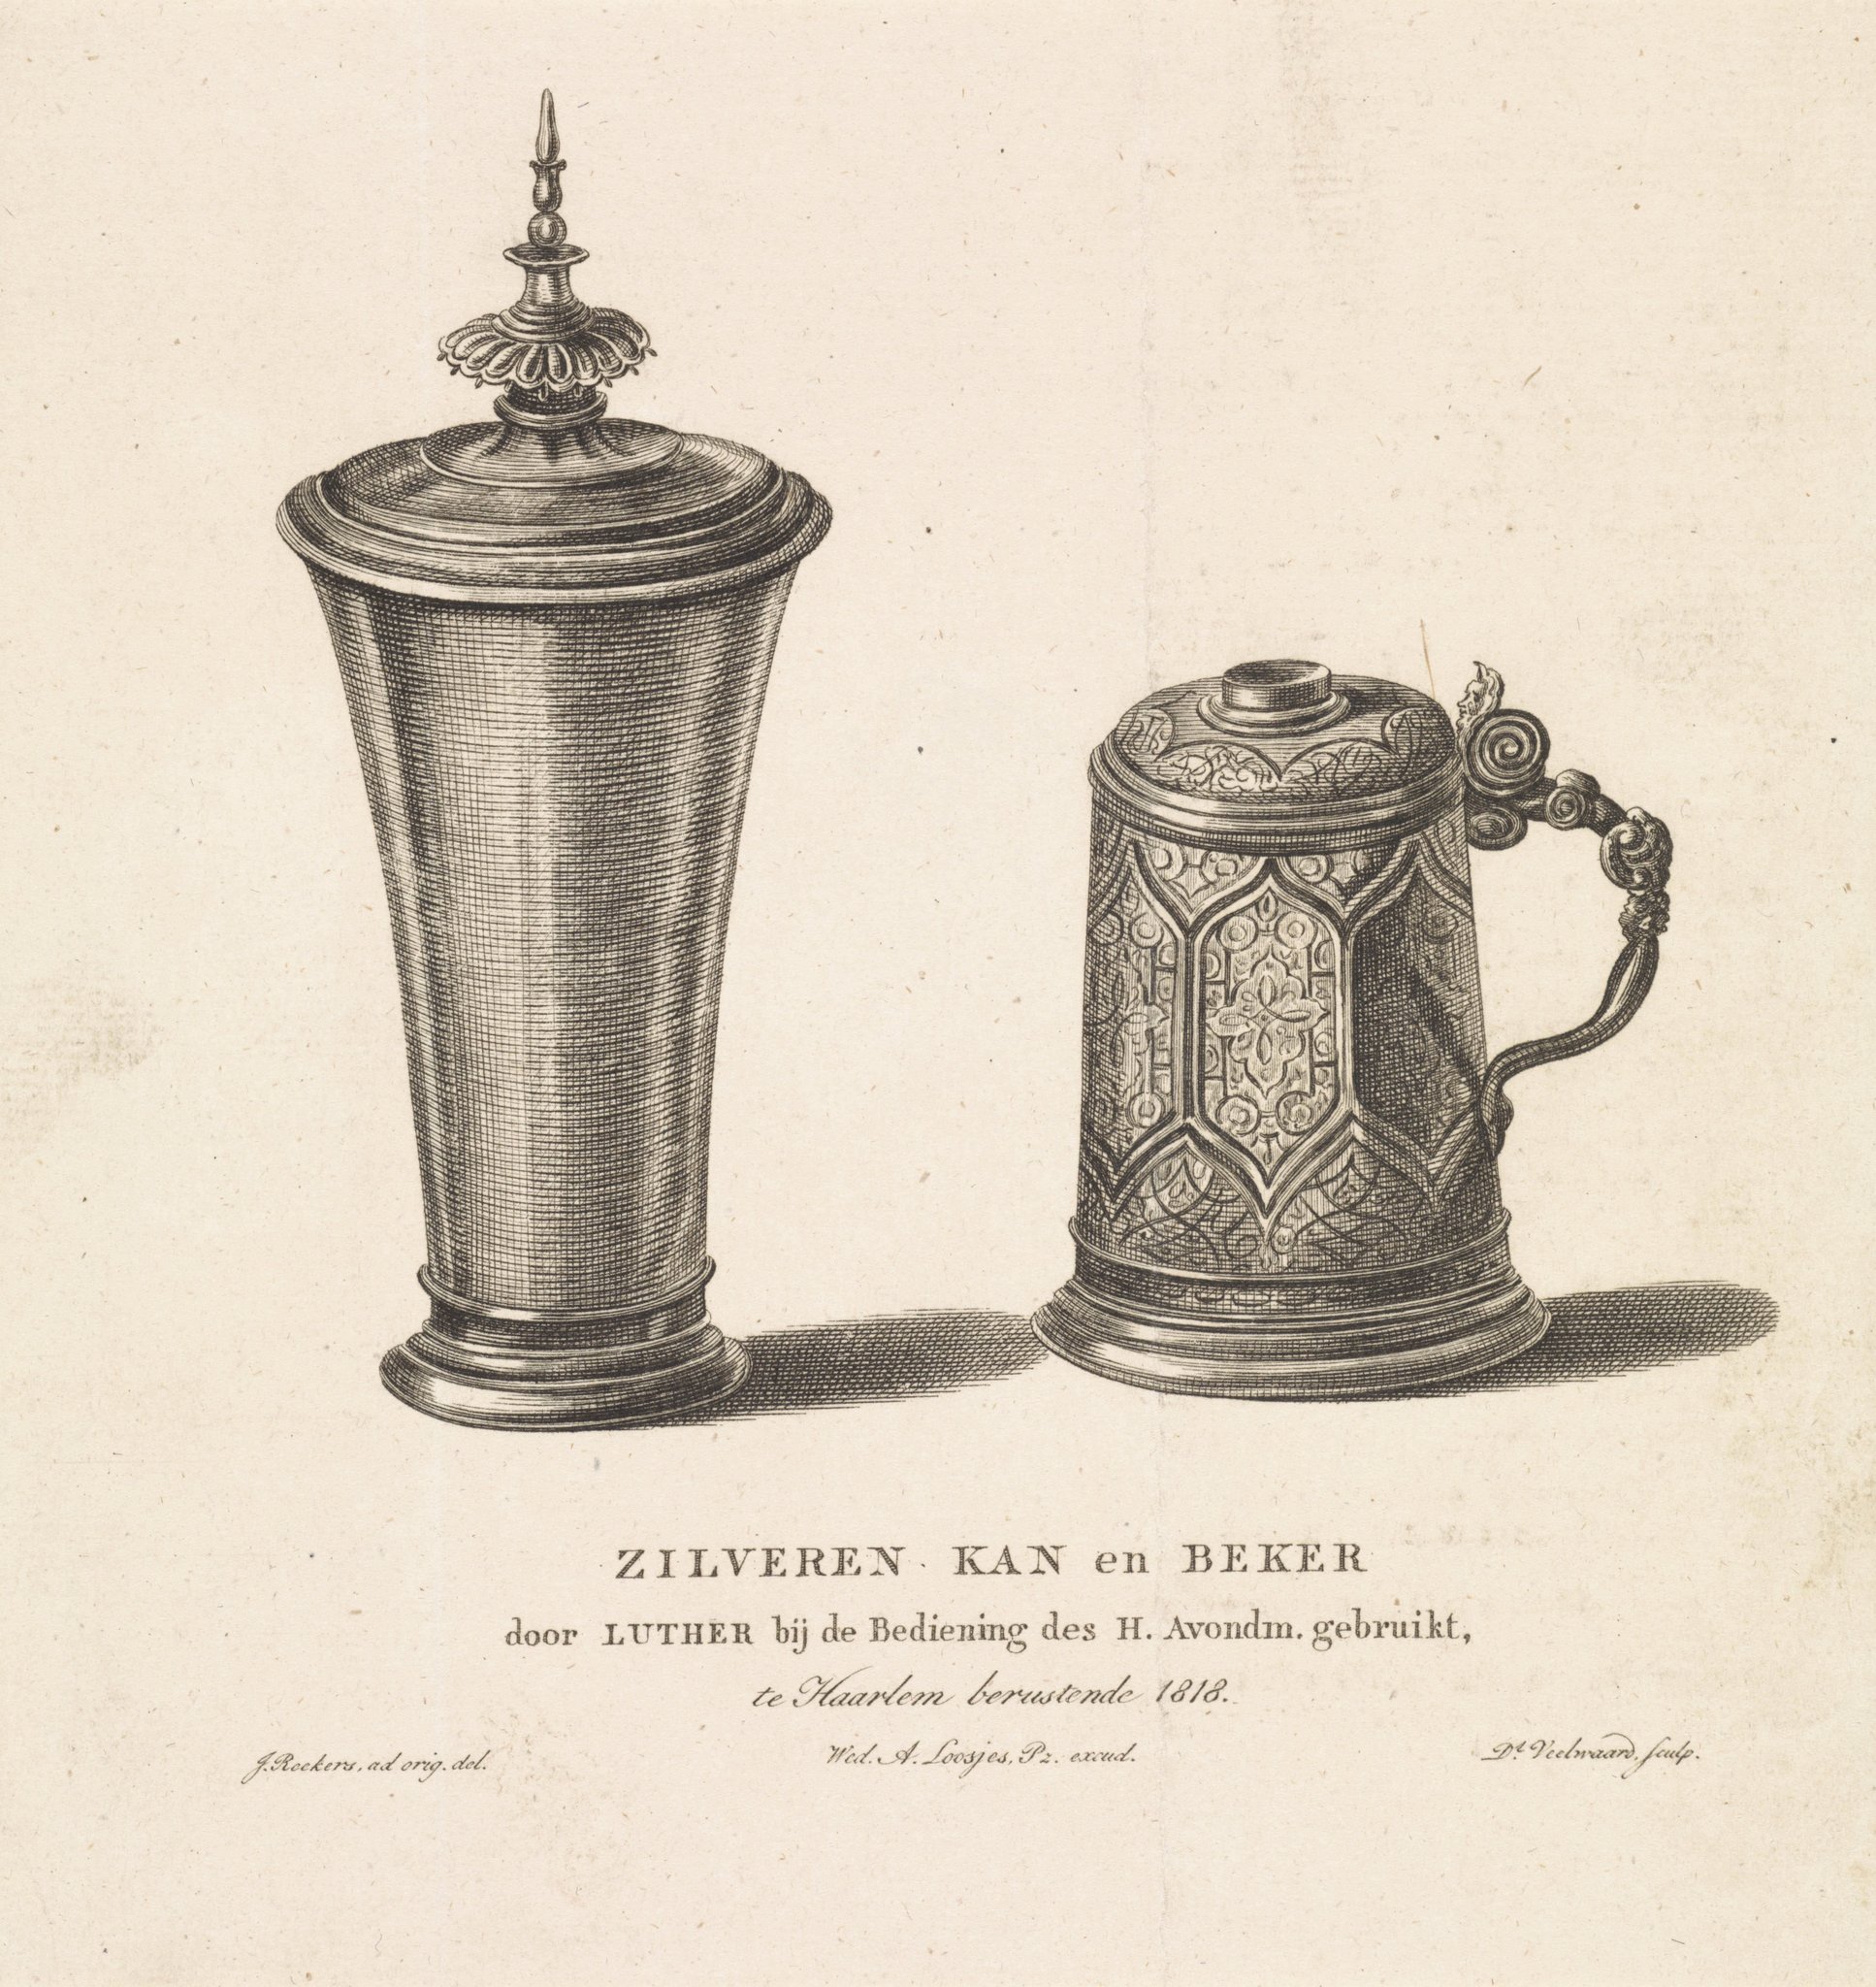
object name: print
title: Zilveren kan en beker door Luther bij de Bediening des H. Avondm. gebruikt, te Haarlem berustende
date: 1818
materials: paper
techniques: engraving, etching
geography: haarlem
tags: priest, martin luther, tankard, mug, beaker, goblet, jar, jug (used as drinking-vessel)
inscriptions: collector's mark: Lugt 2228